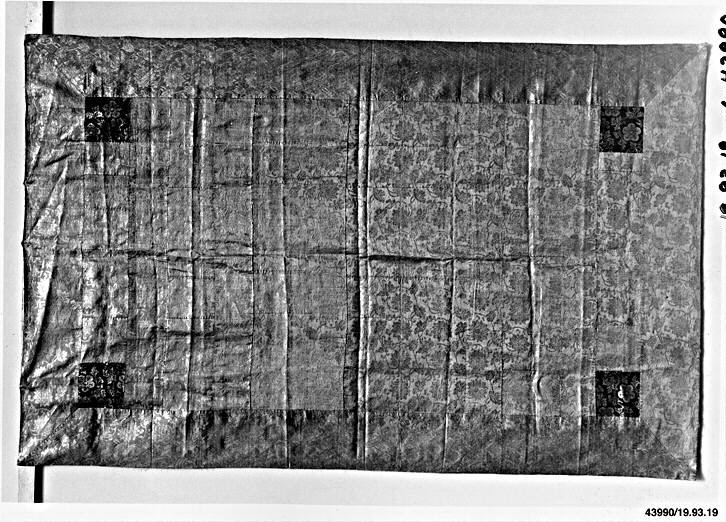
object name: robe, priest's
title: Seven-Panel Buddhist Monk’s Vestment (Shichijō kesa) with Lotus Arabesque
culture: japanese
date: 1601-1633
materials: gold, silk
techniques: patterning, weave